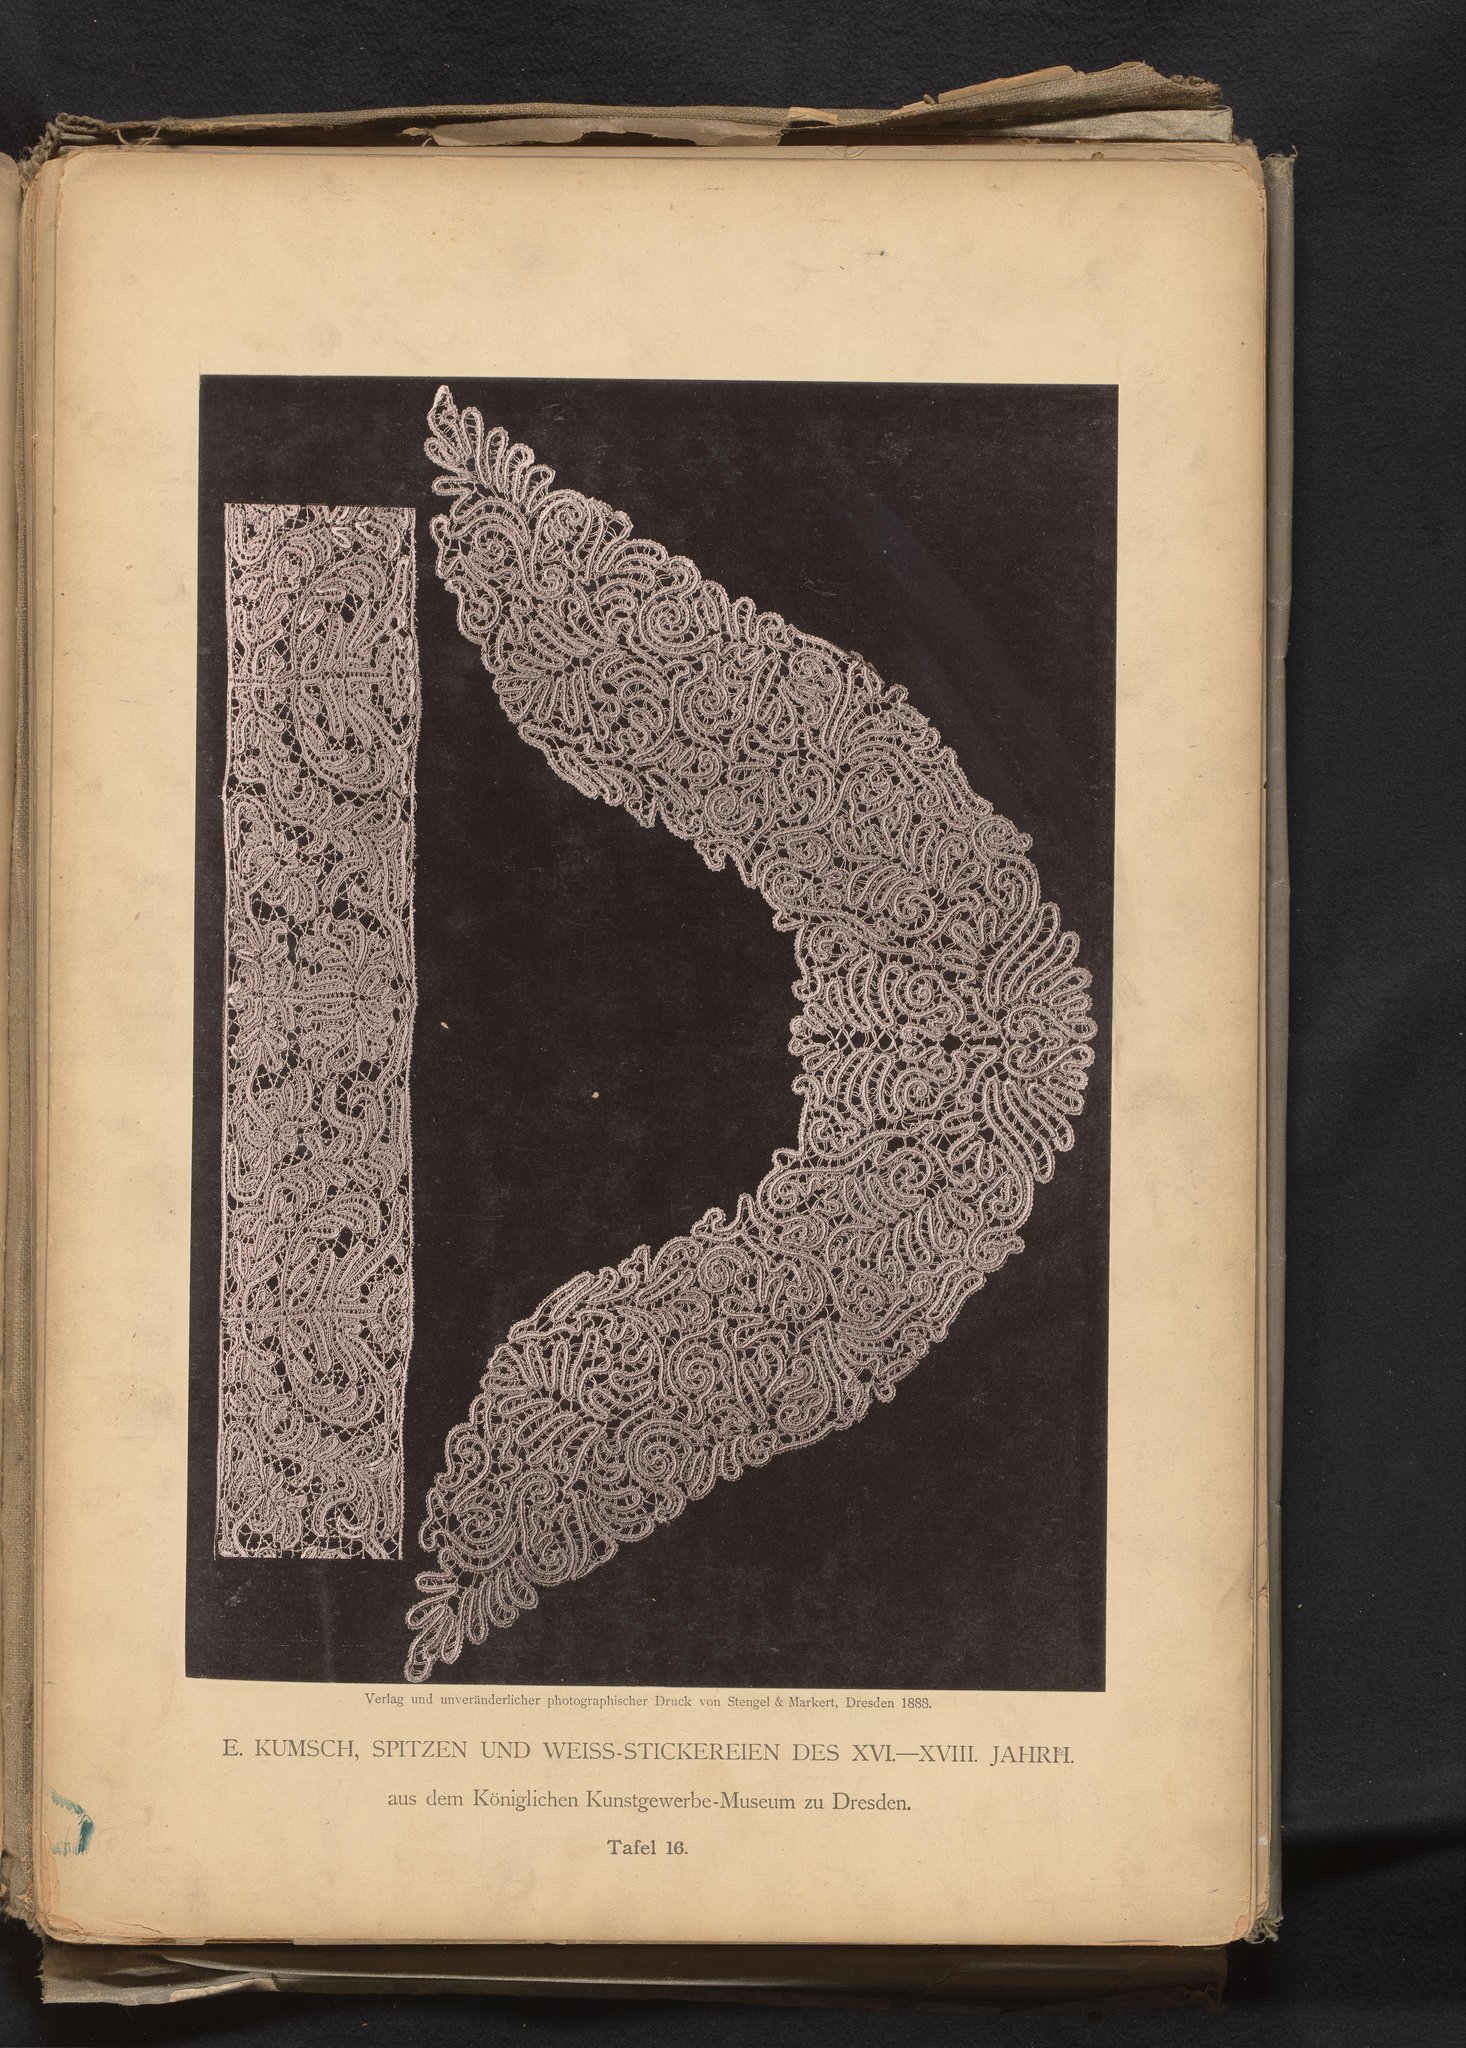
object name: photomechanical print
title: Twee stukken 17de-eeuws Spaans kant uit de collectie van het Kunstgewerbemuseum in Dresden, Duitsland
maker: Anonymous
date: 1888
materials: paper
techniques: photograph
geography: dresden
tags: lace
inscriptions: inscription: ‘E. KUMSCH, SPITZEN UND WEISS-STICKEREIEN DES XVI.-XVIII. JAHRH./ aus dem Königlichen Kunstgewerbe-Museum zu Dresden’, number: ‘Tafel 16.’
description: Deze prent maakt deel uit van een omslag met 49 prenten en een lijst van afbeeldingen.